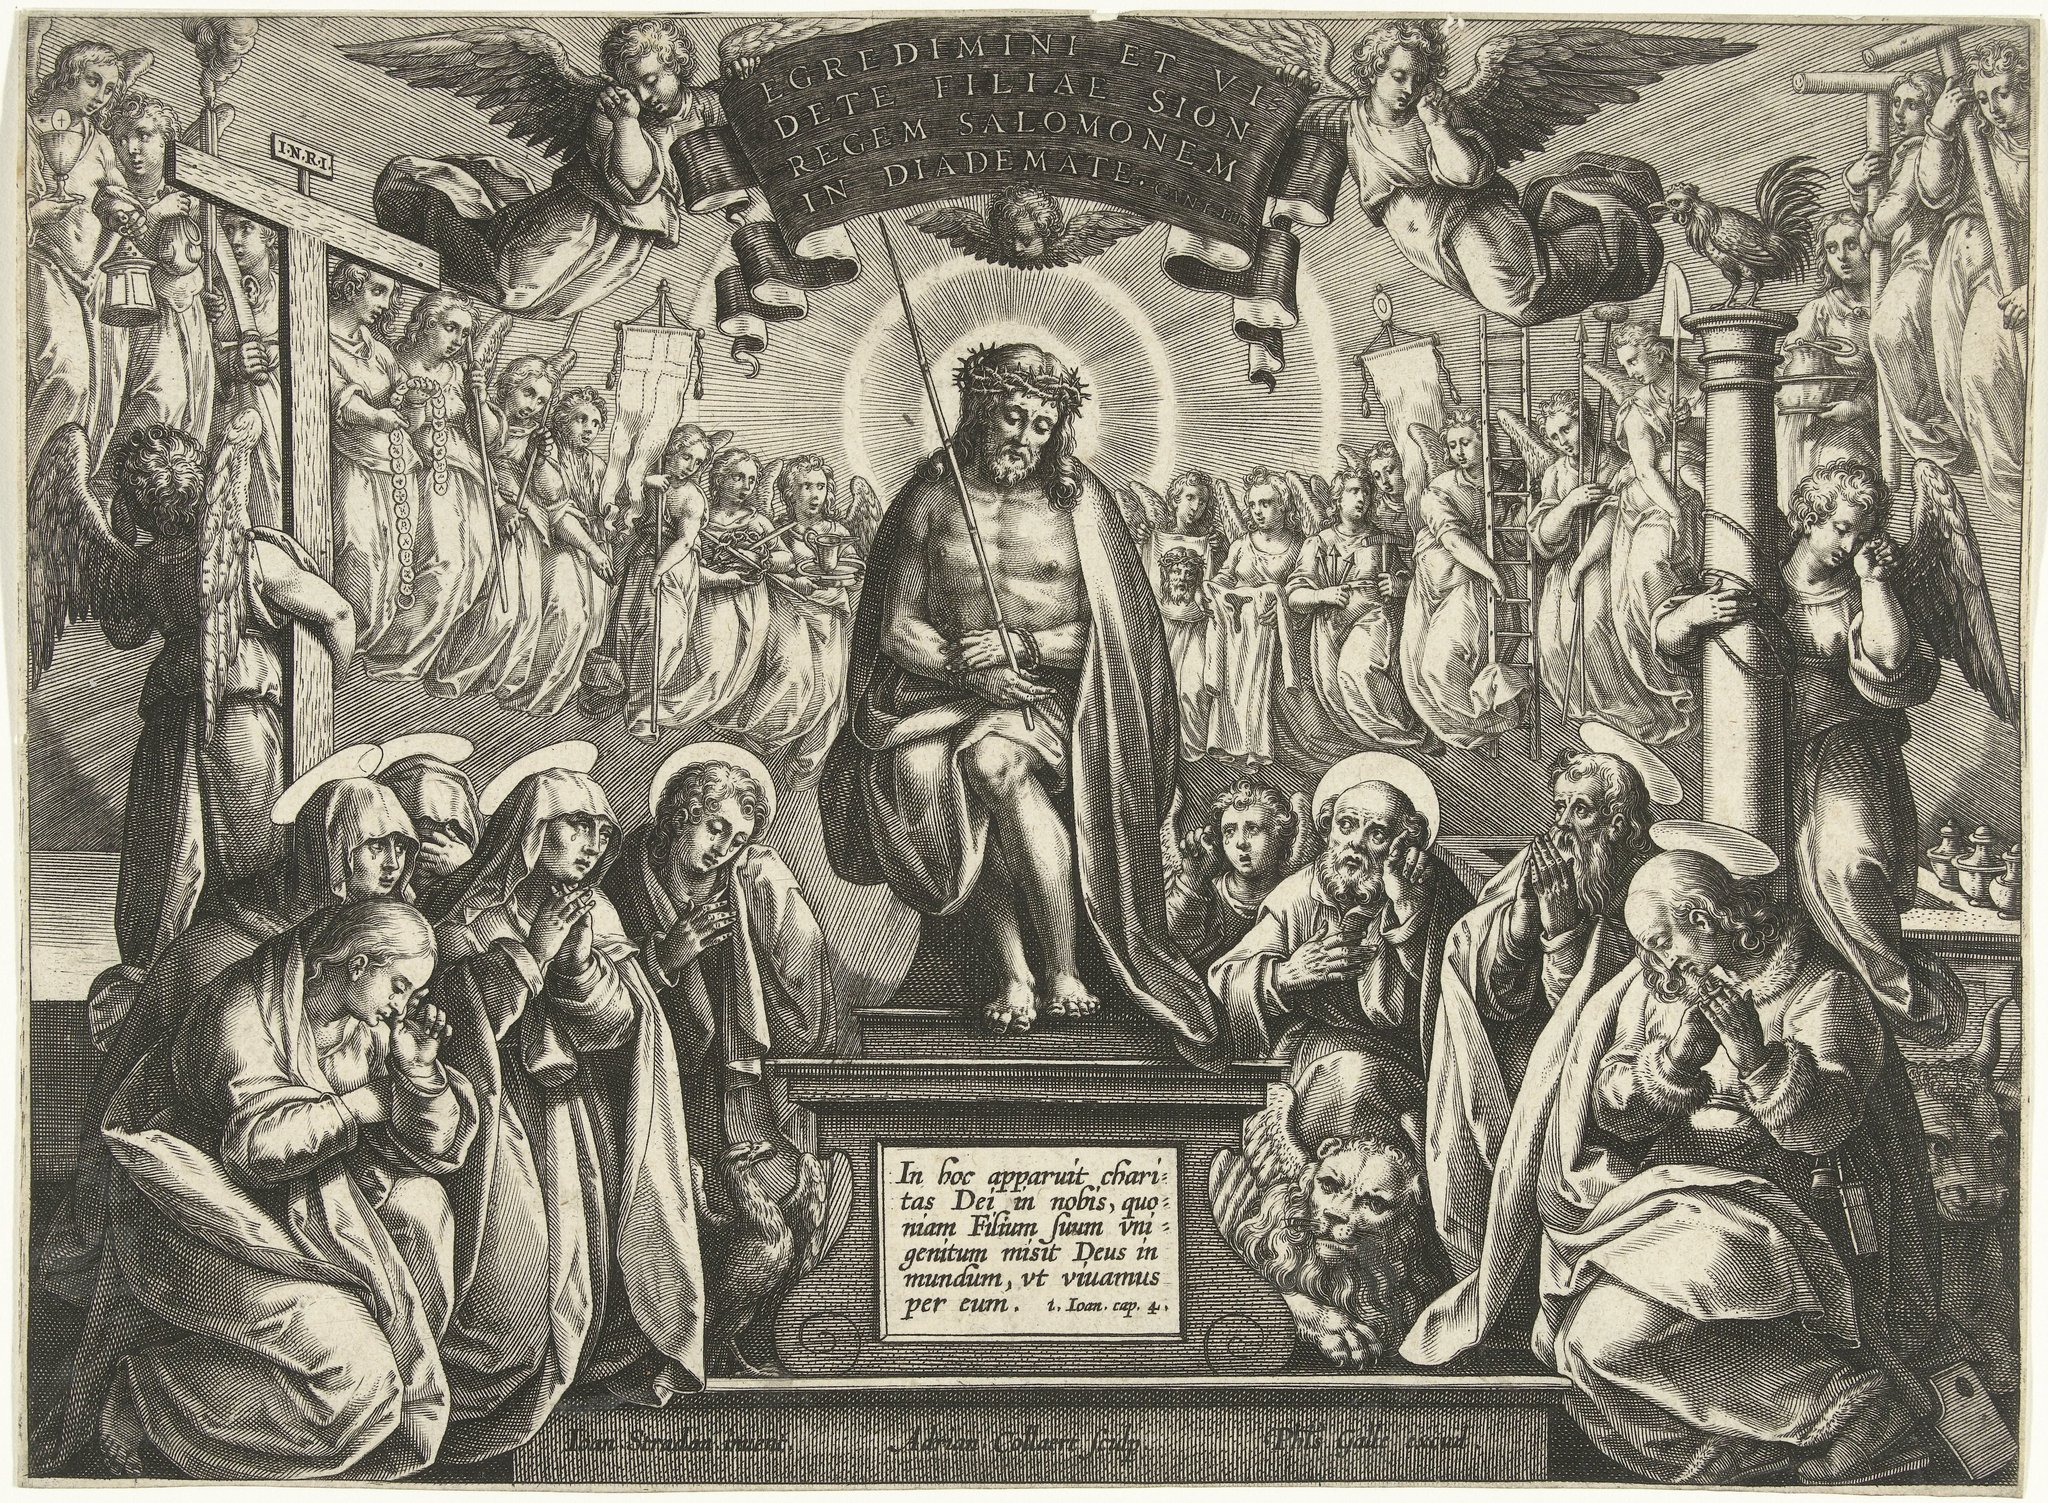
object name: print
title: Man van Smarten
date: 1570-1618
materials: paper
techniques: engraving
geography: antwerp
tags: the four evangelists together (author portraits), man of sorrows together with mary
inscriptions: collector's mark: Lugt 2228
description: Christus, zijn handen gebonden, zit op een zuil met doornenkroon op zijn hoofd. Rondom hem knielen de vier evangelisten, Maria Magdalena, de Maagd Maria, en een andere vrouw. Ze huilen. Boven Christus diverse engelen met de passiewerktuigen. De centrale zuil heeft een Latijnse inscriptie. Boven Christus vliegen twee engelen met een banderol met een Latijnse inscriptie.